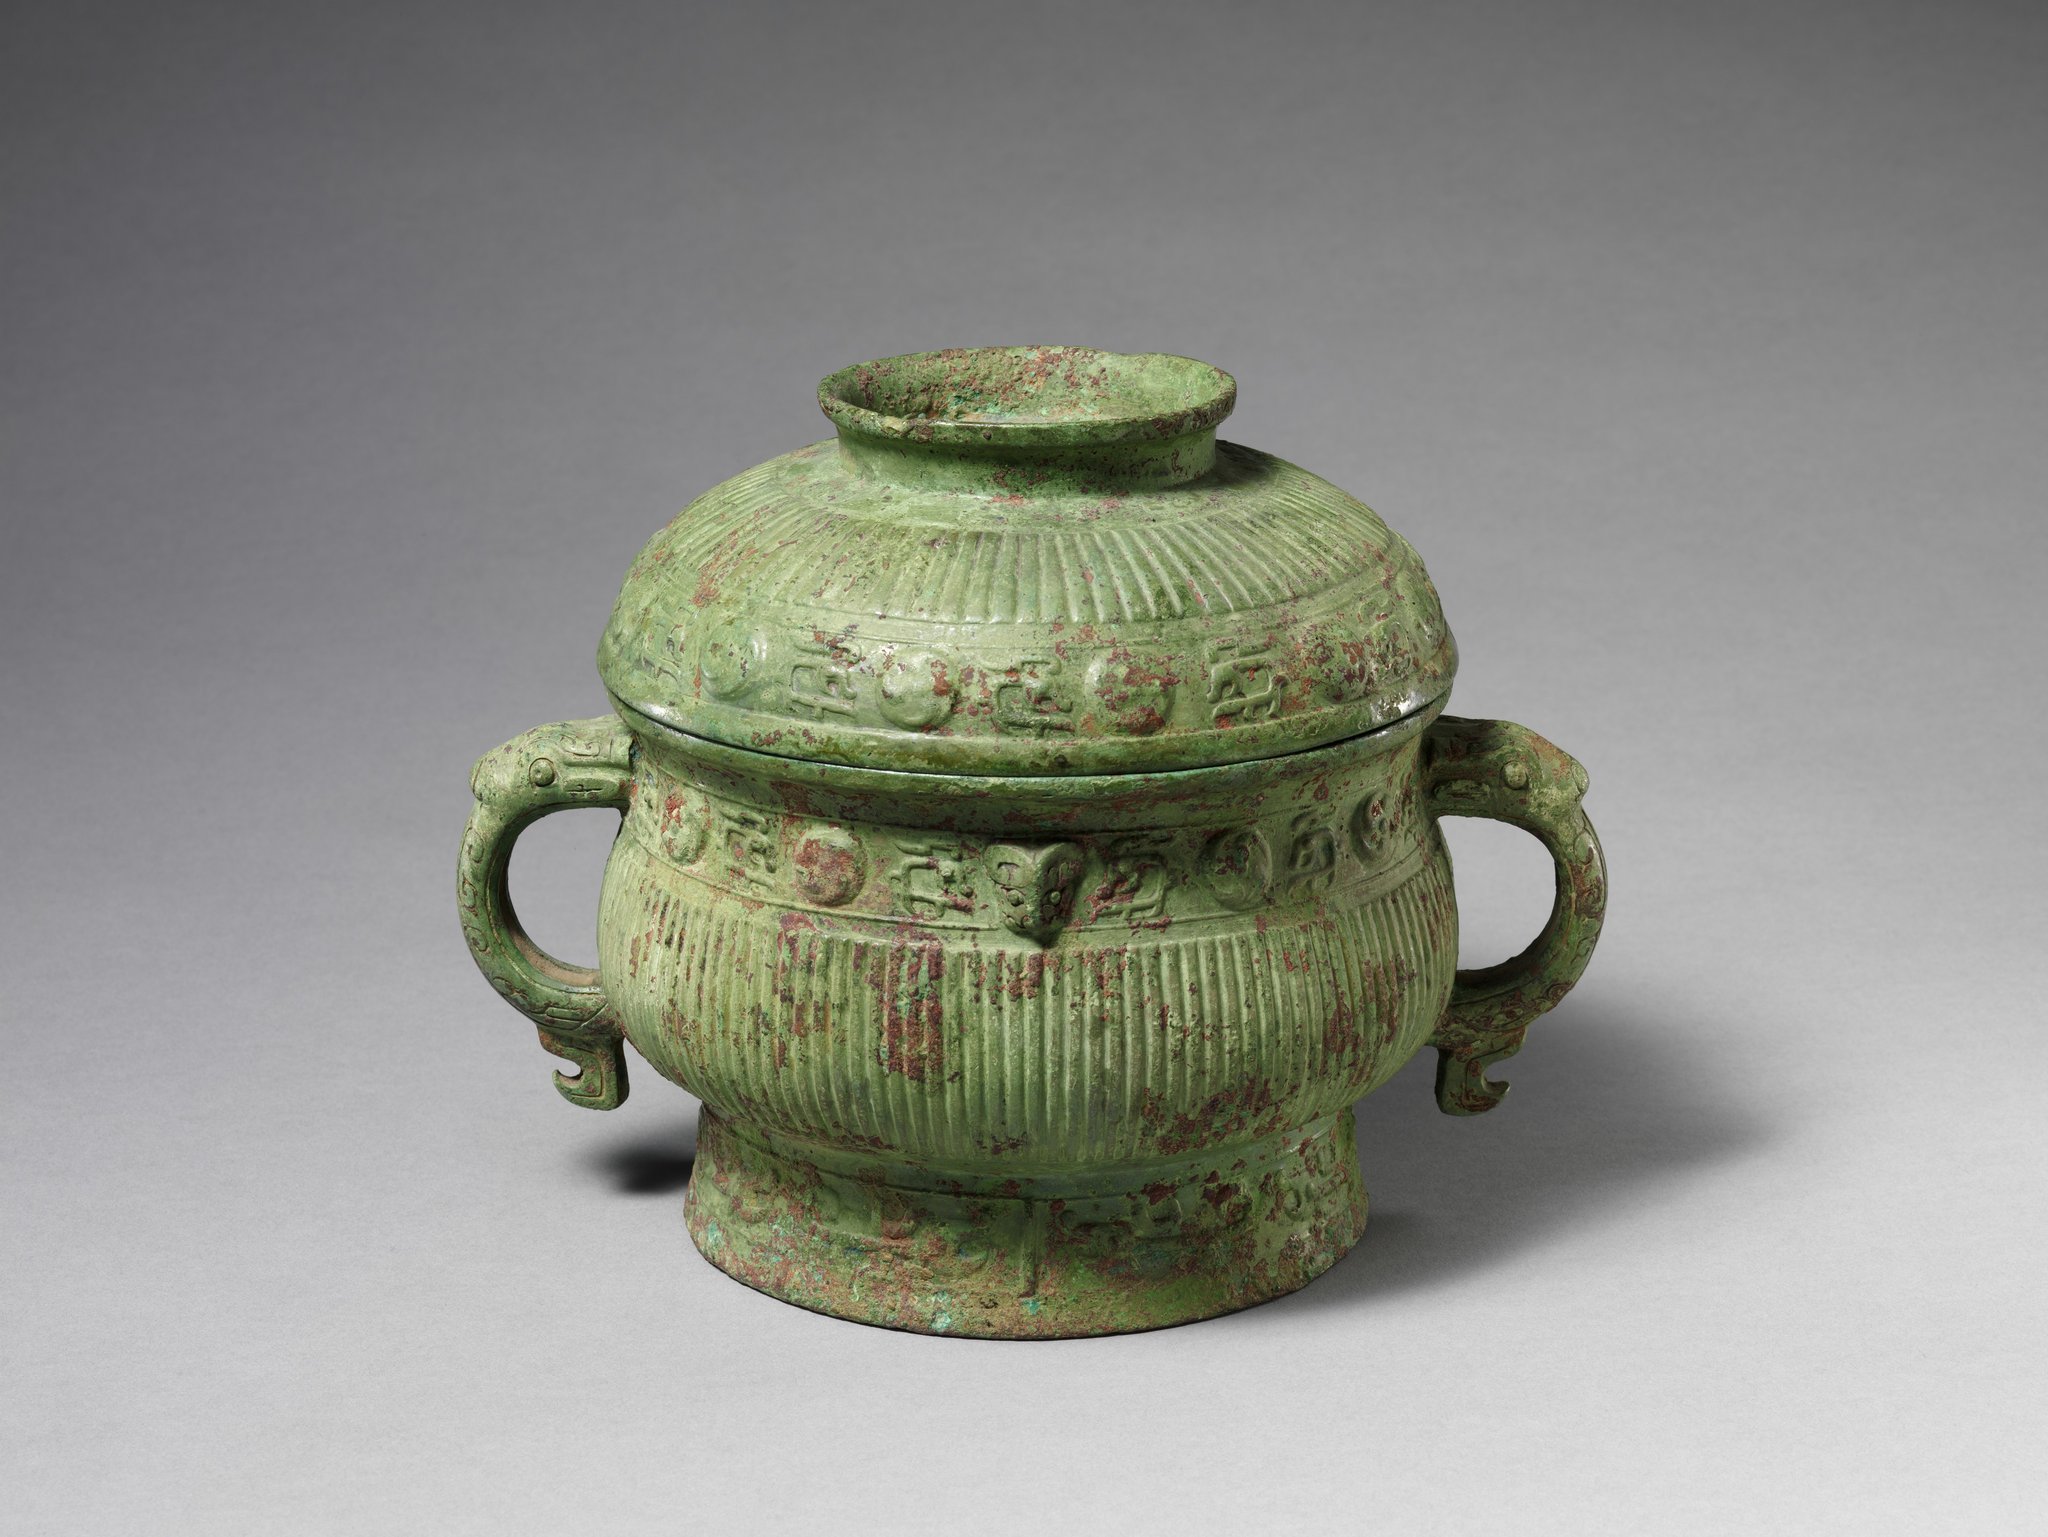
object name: vessel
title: Grain serving vessel (Gui)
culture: chinese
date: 1034-968 BCE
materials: bronze